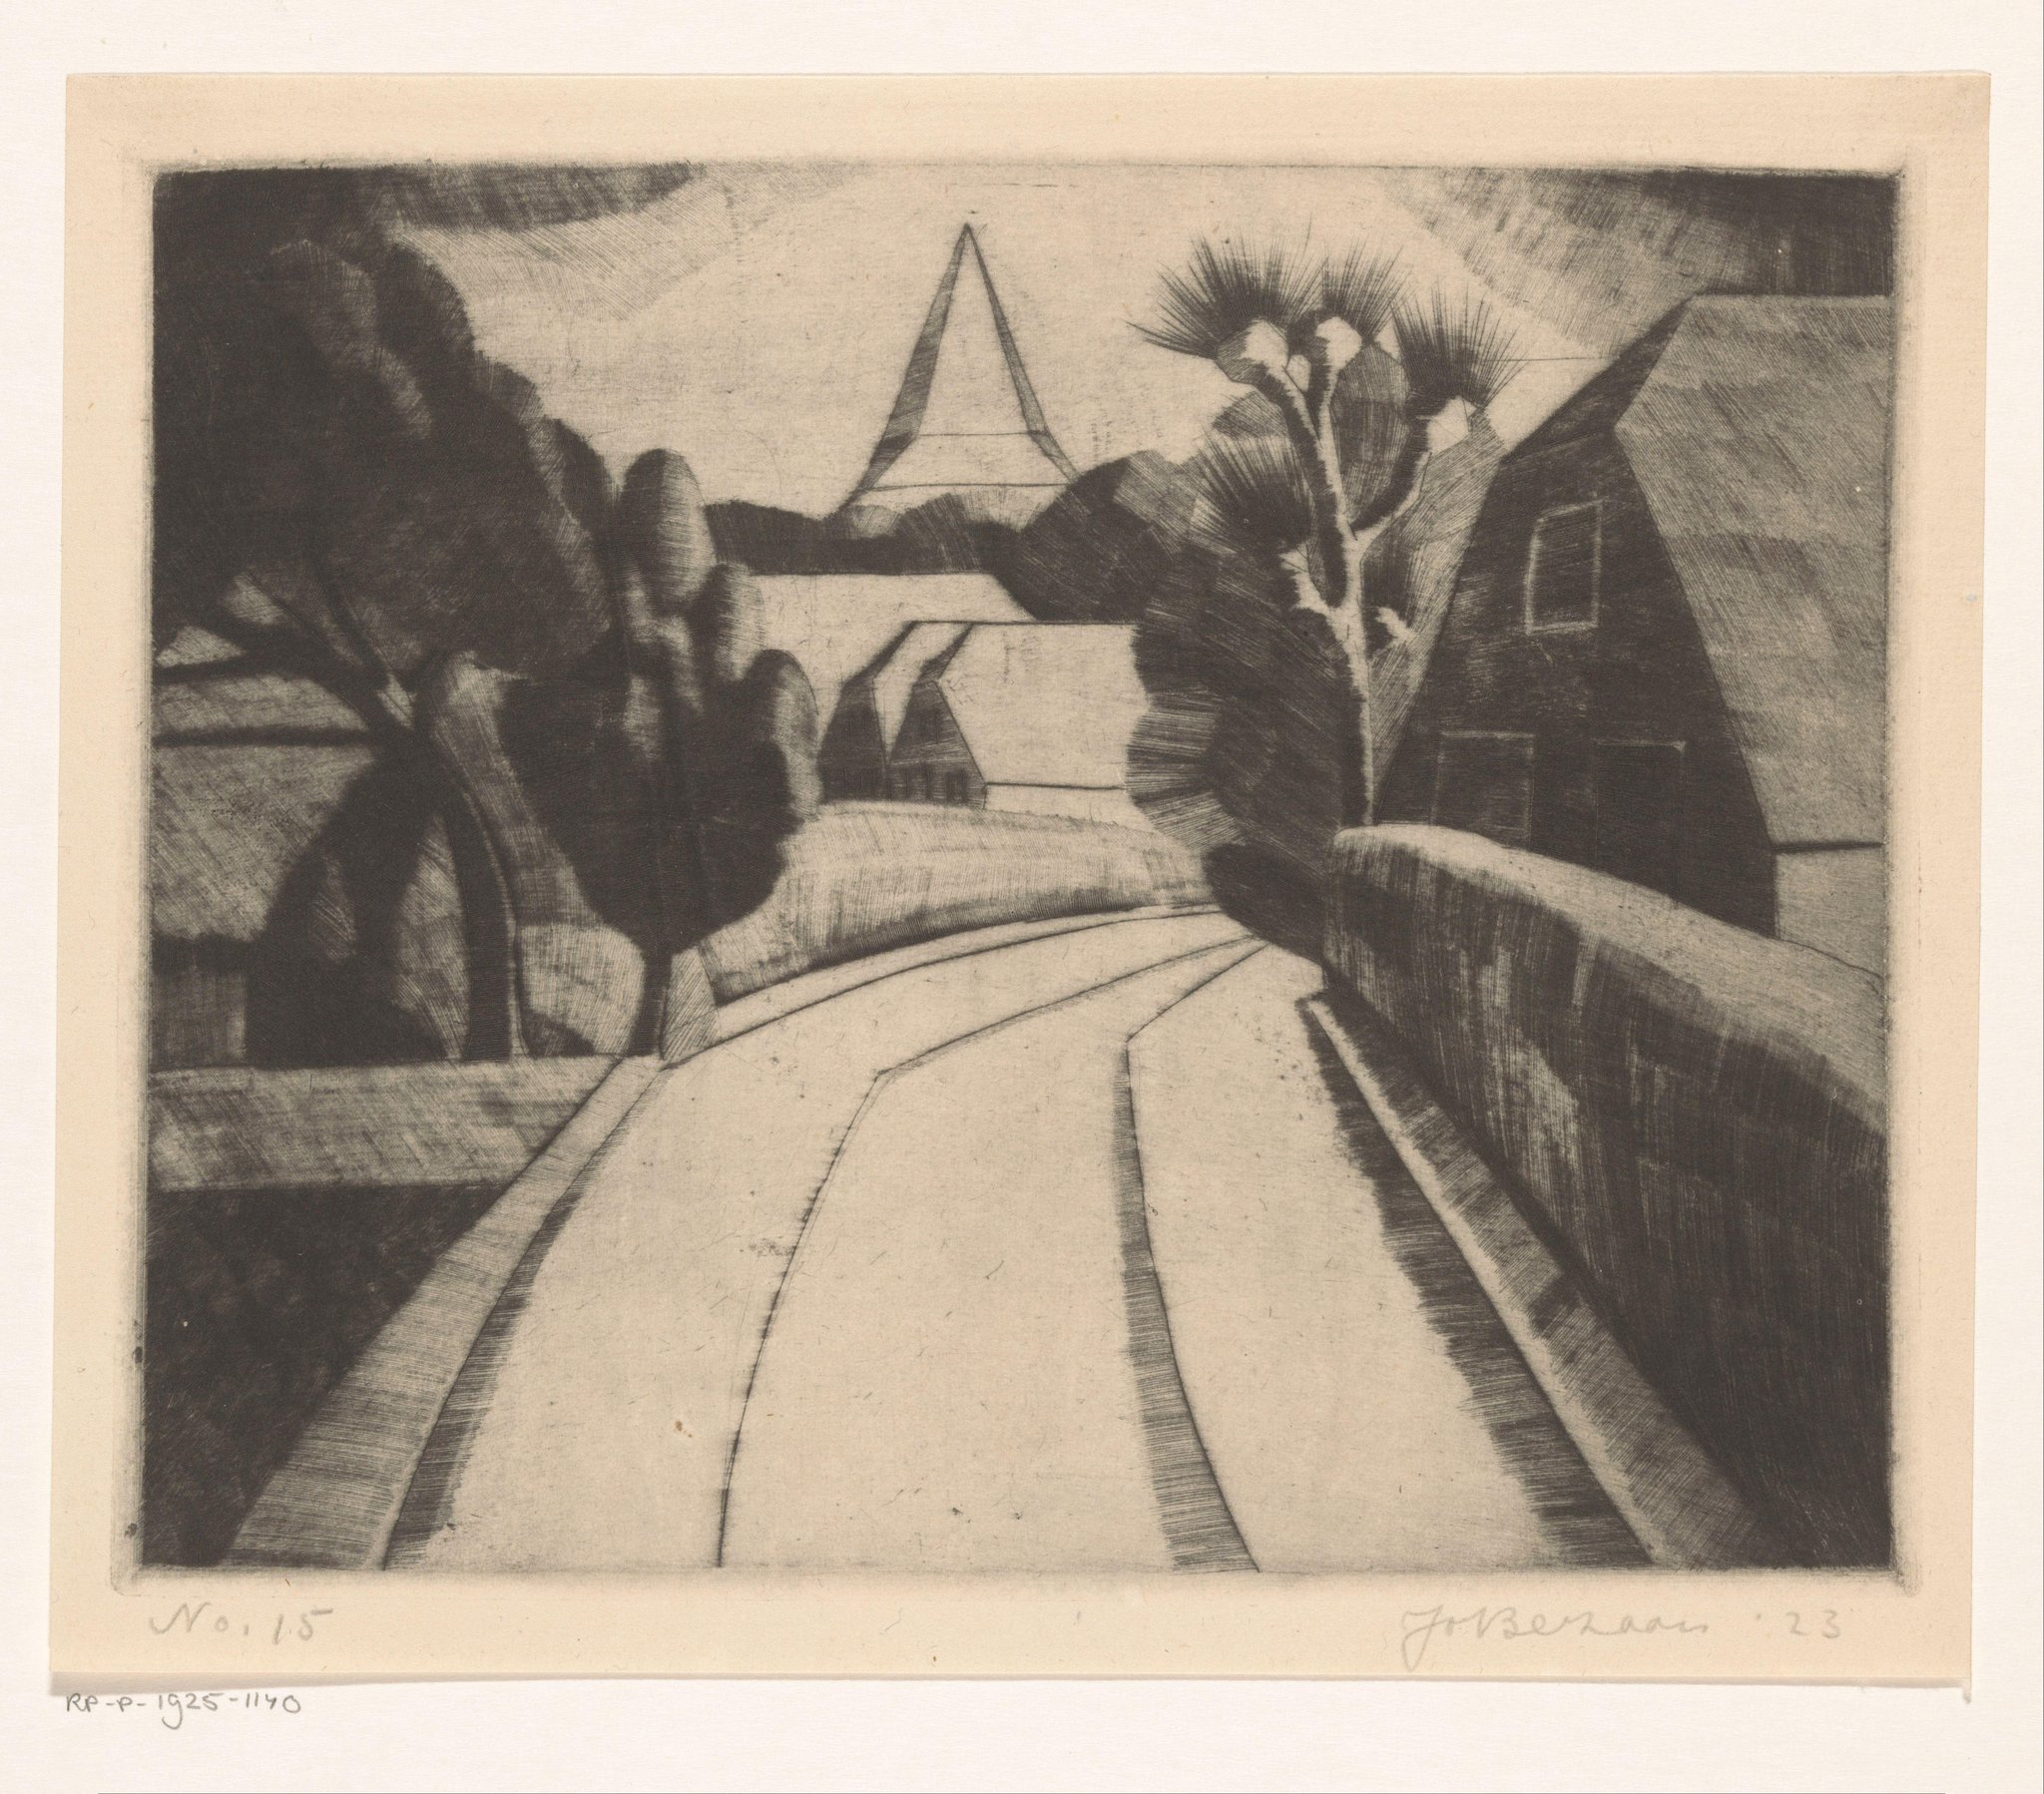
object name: print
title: Ingang van Putten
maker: jo bezaan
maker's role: draughtsman, print maker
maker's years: 1894-1952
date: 1923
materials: paper, ink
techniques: drypoint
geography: putten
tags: village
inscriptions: signature and date: ‘JoBezaan ´23’, collector's mark: Lugt 2228, number: ‘No. 15’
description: Dorpsweg met een kromming naar rechts, aan weerszijden boerenhuizen en op de achtergrond een kerktoren.